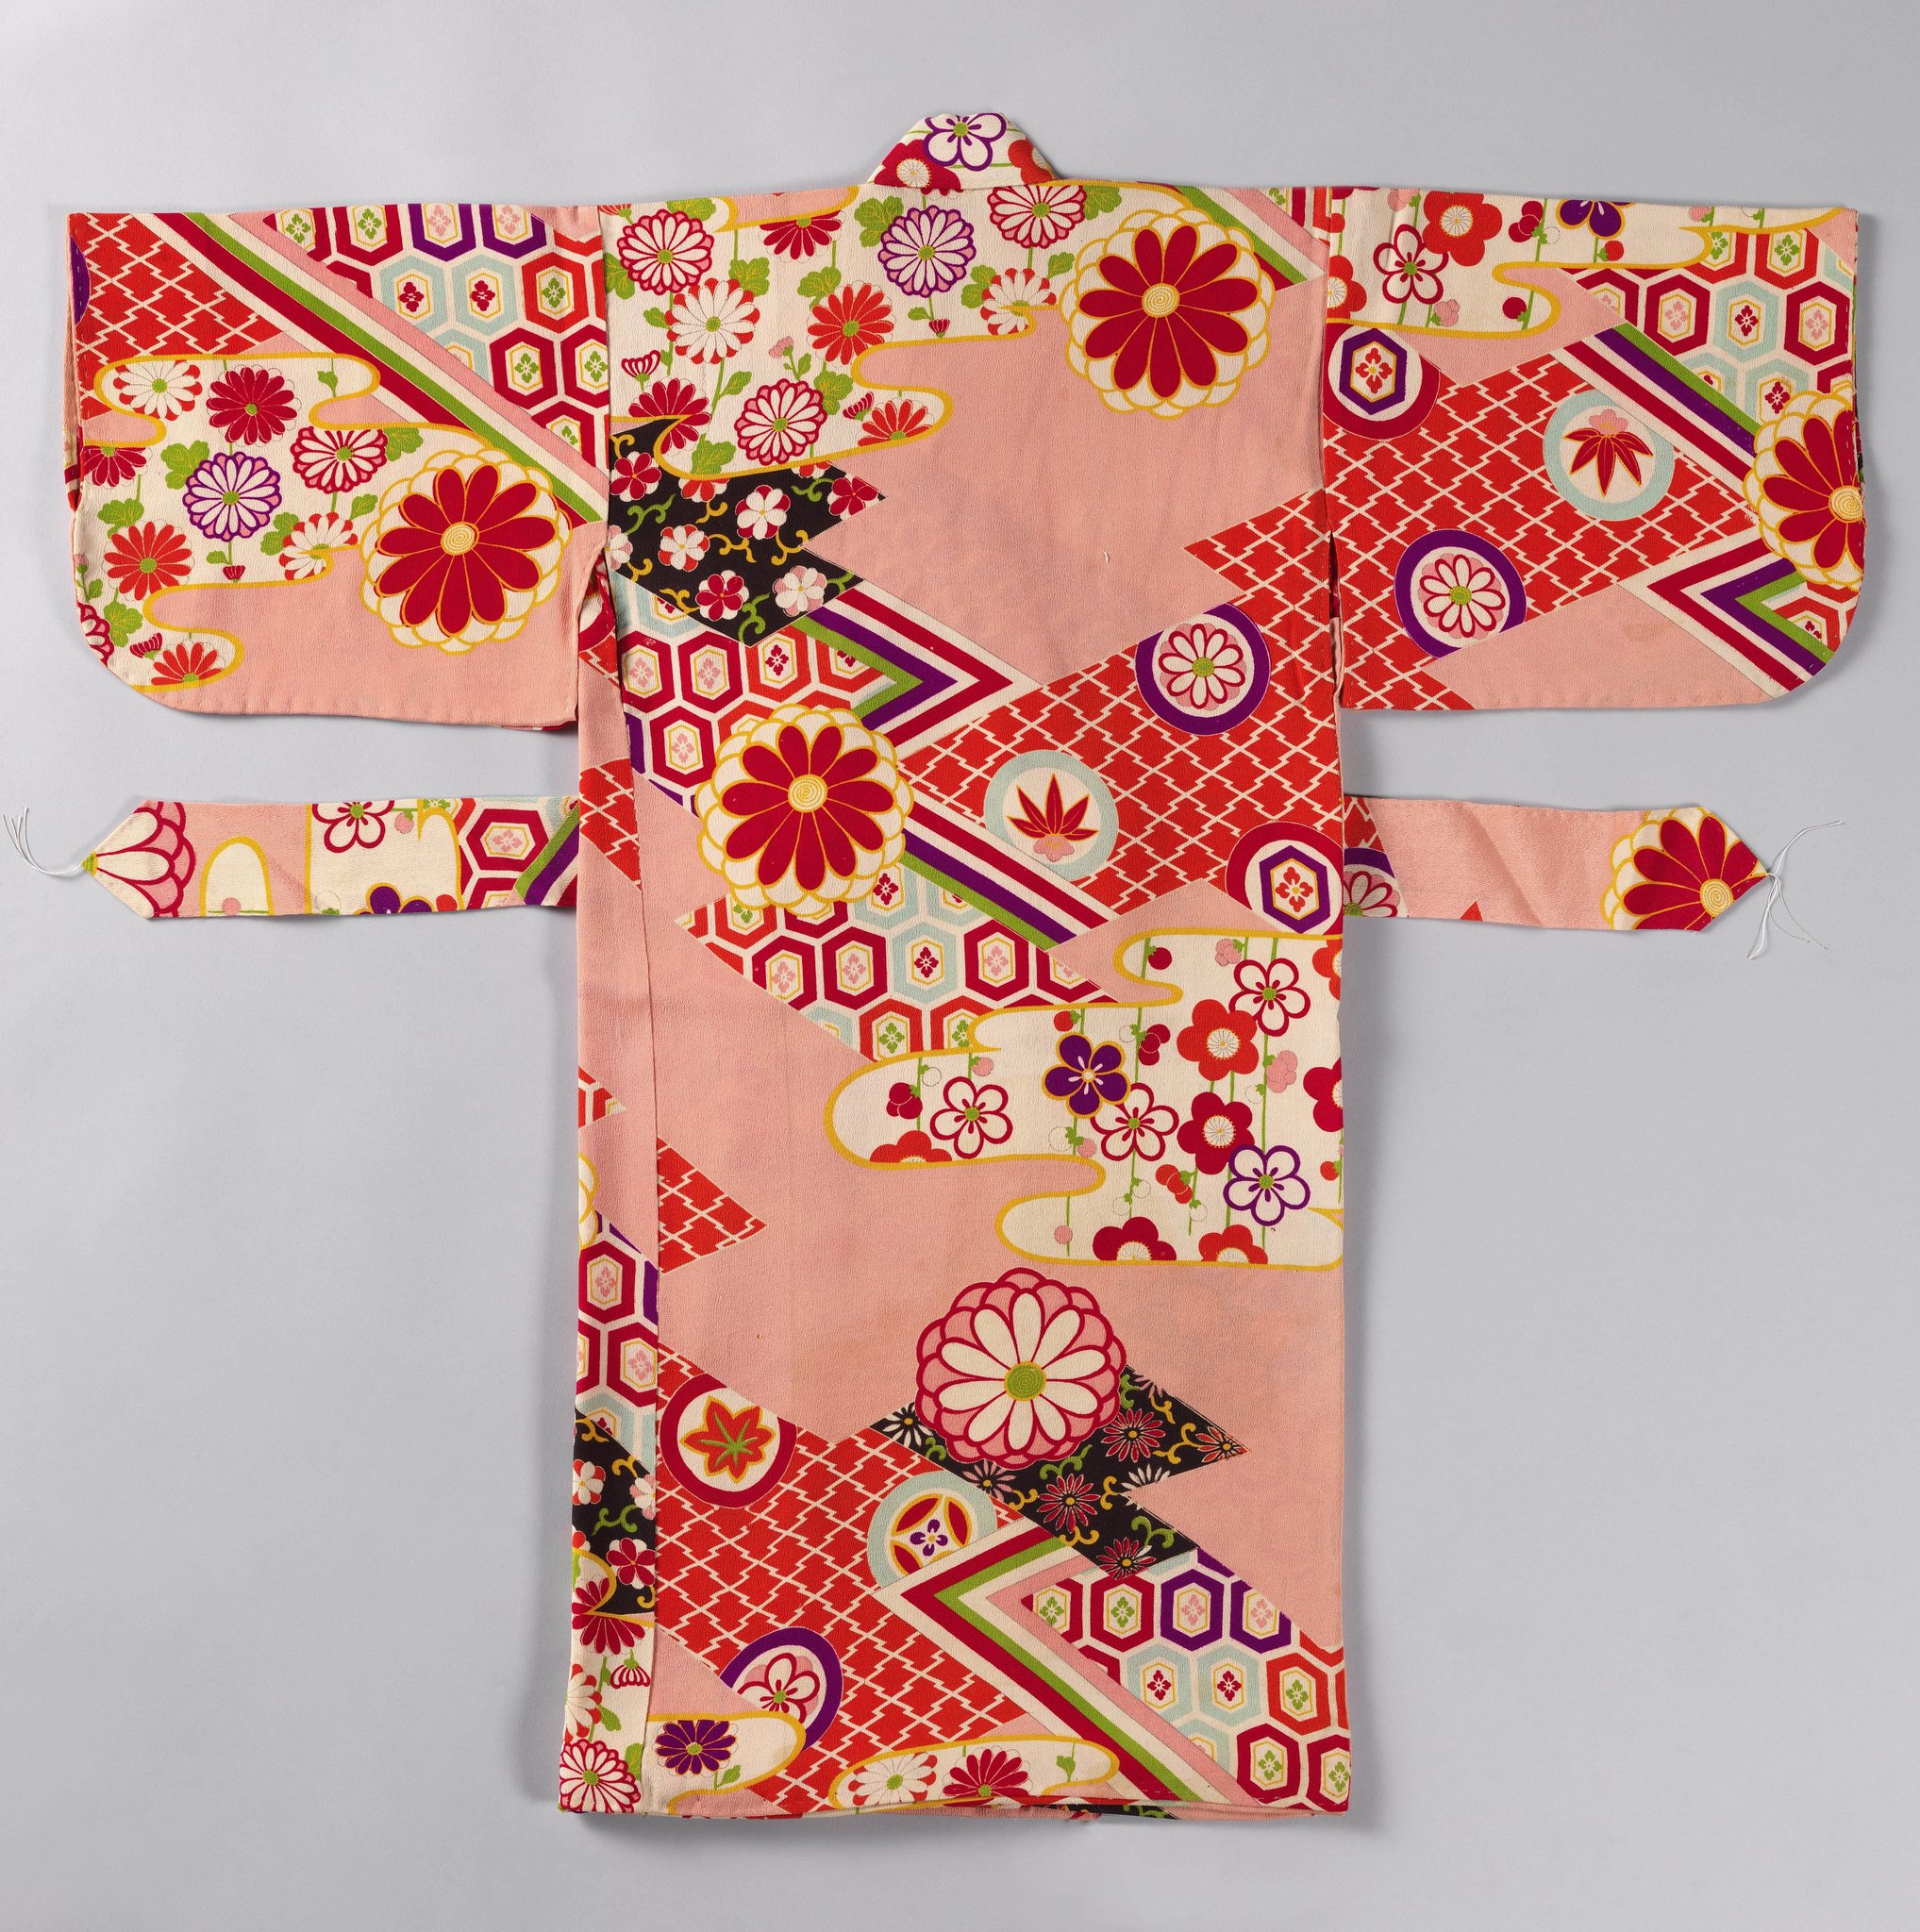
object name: kimono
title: Meisjes miyamairi kimono met geometrische- en bloem-motieven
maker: Anonymous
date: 1920-1940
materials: silk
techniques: painting, weave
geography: japan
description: Formele kimono voor een meisje voor het eerste bezoek aan een Shinto schrijn, met een versiering van hoekige en wolkvormige vlakken met geometrische patronen en motieven van prunus, chrysant en bamboe, tegen een roze achtergrond. Roze crepe zijde (chirimen) met een gestencilde yuzen decoratie. Voering van rode zijde met tie-dye versiering (shibori).